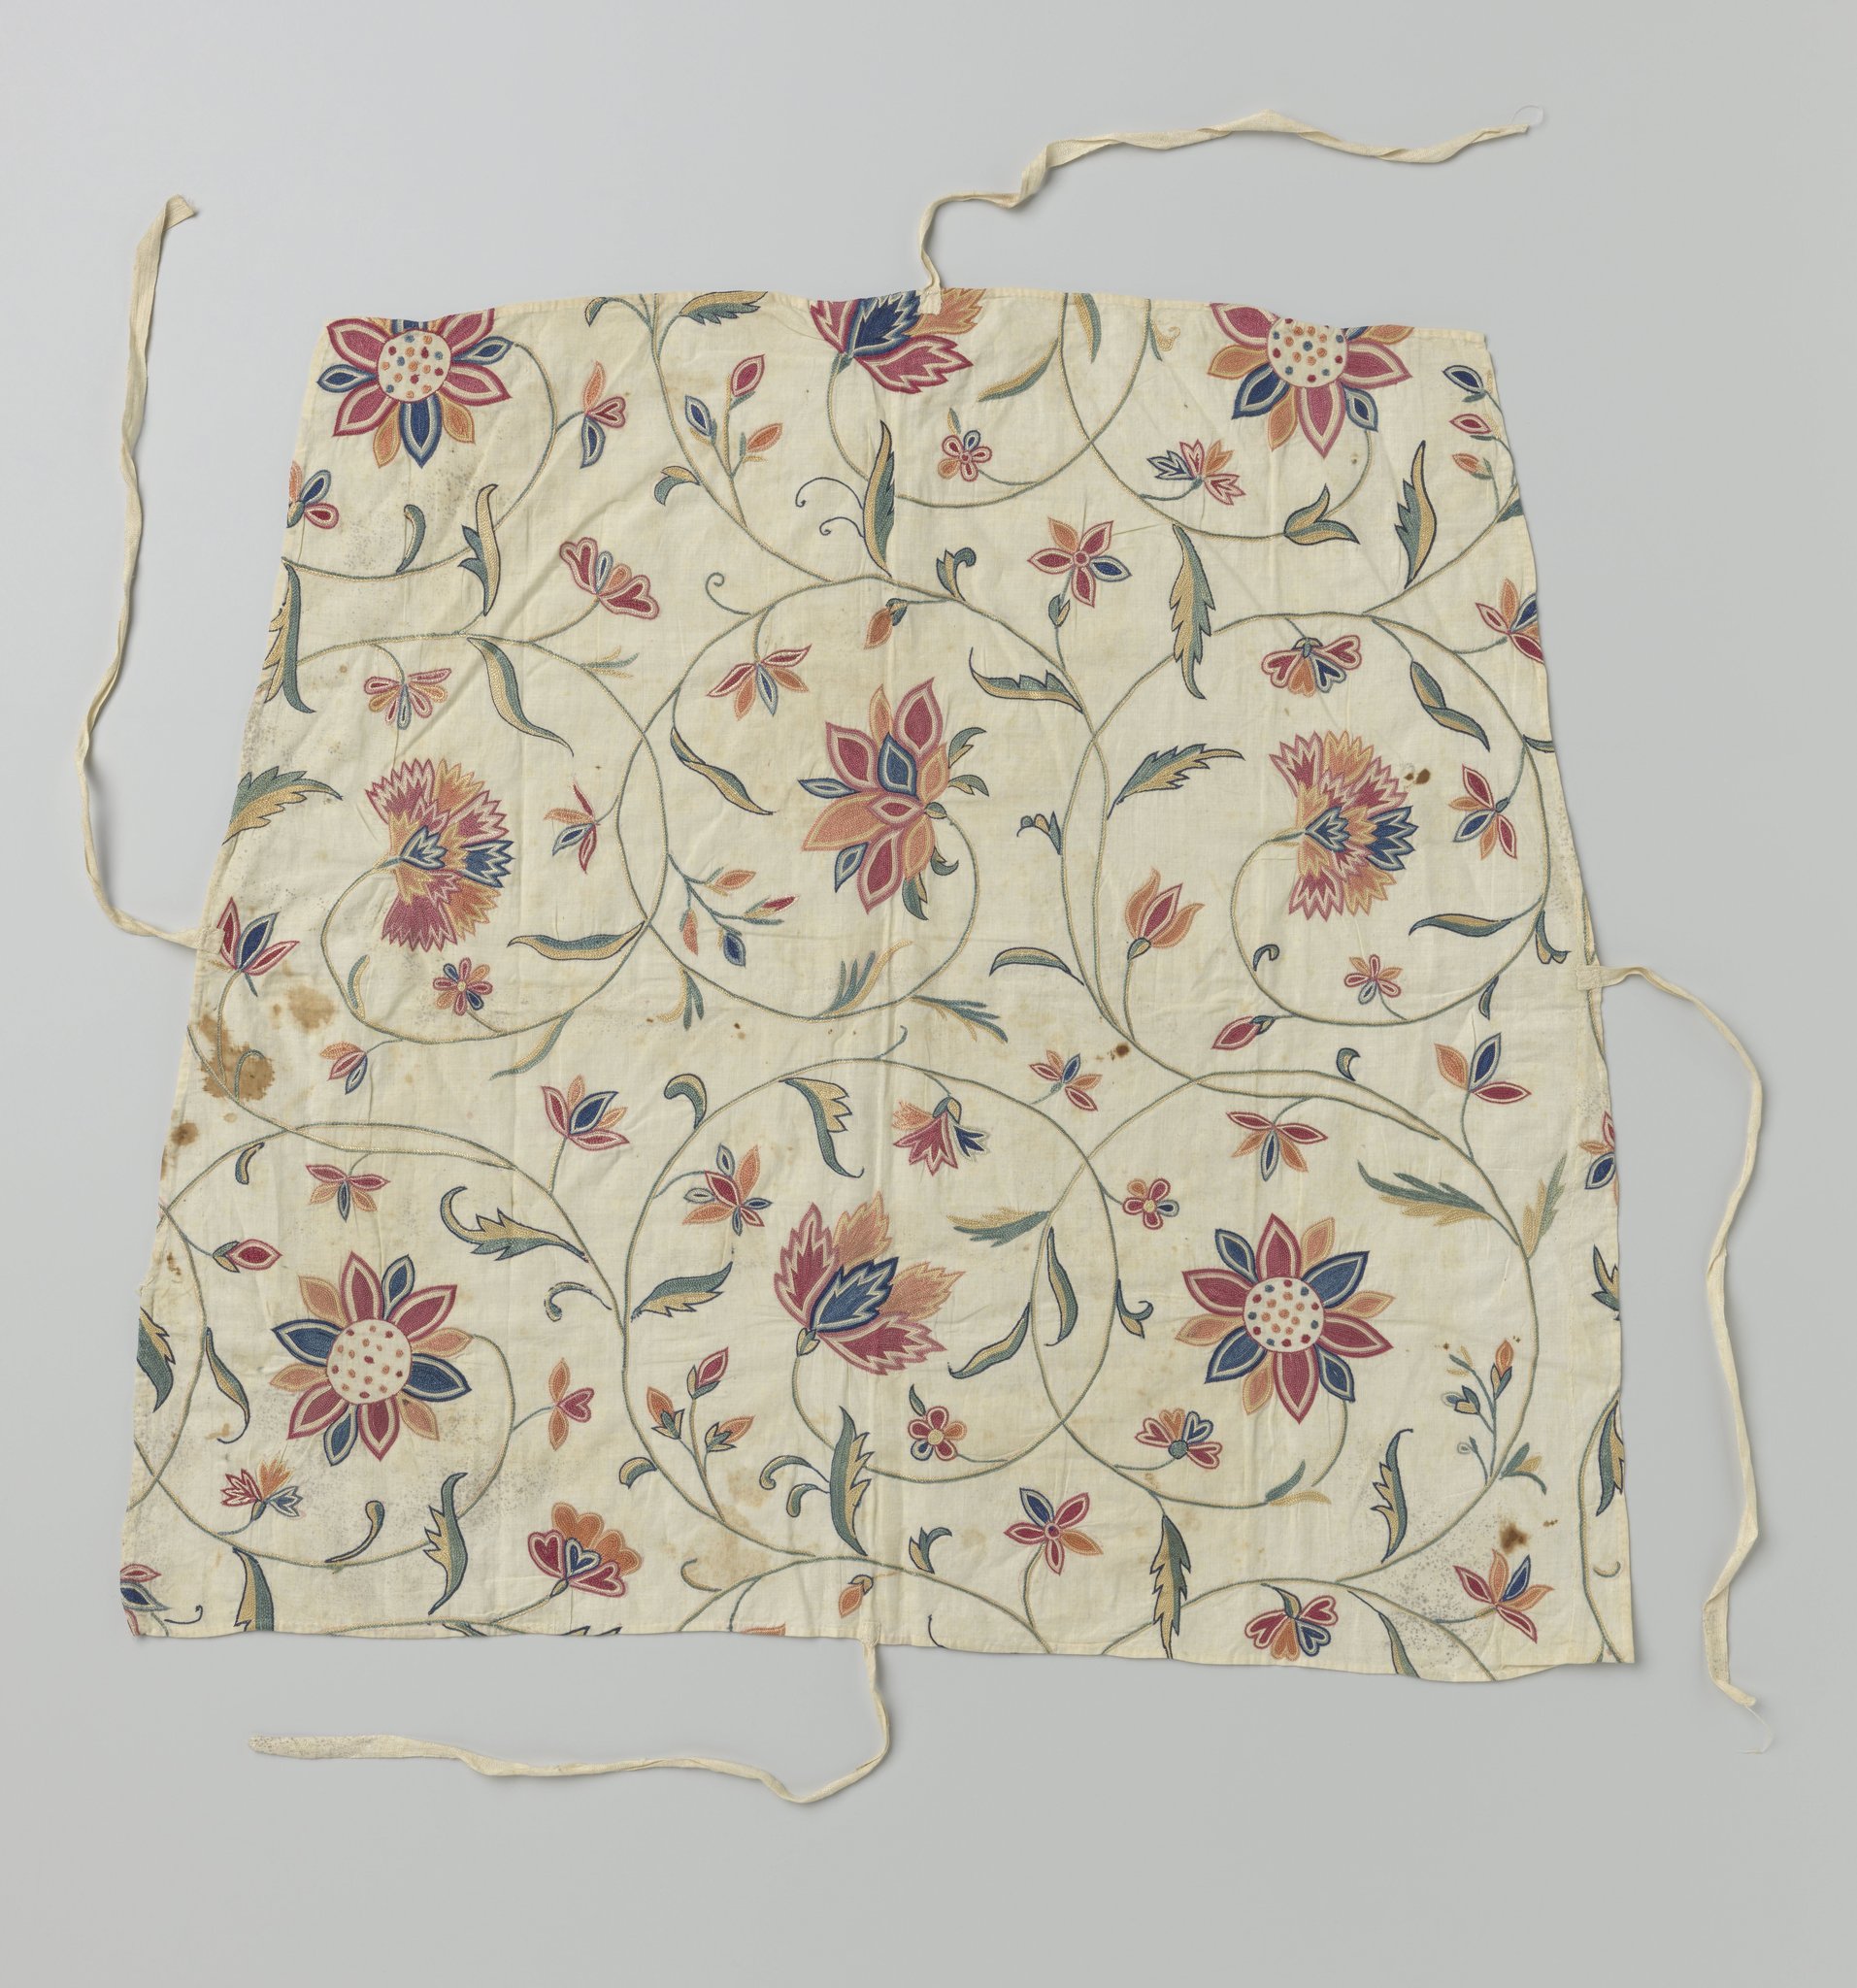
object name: bedspread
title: Fragment van een sprei van oosterse textiel met borduurwerk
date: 1690-1710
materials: cotton, silk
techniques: embroidered, weave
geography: east indies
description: Fragment van een veelkleurig getamboereerde Indo-Perzische sprei, versierd met voluten en bloemen. Vermaakt tot een trapeziumvormige stoelovertrek. Met een aangenaaid linnen bandje op het midden der vier zijden.